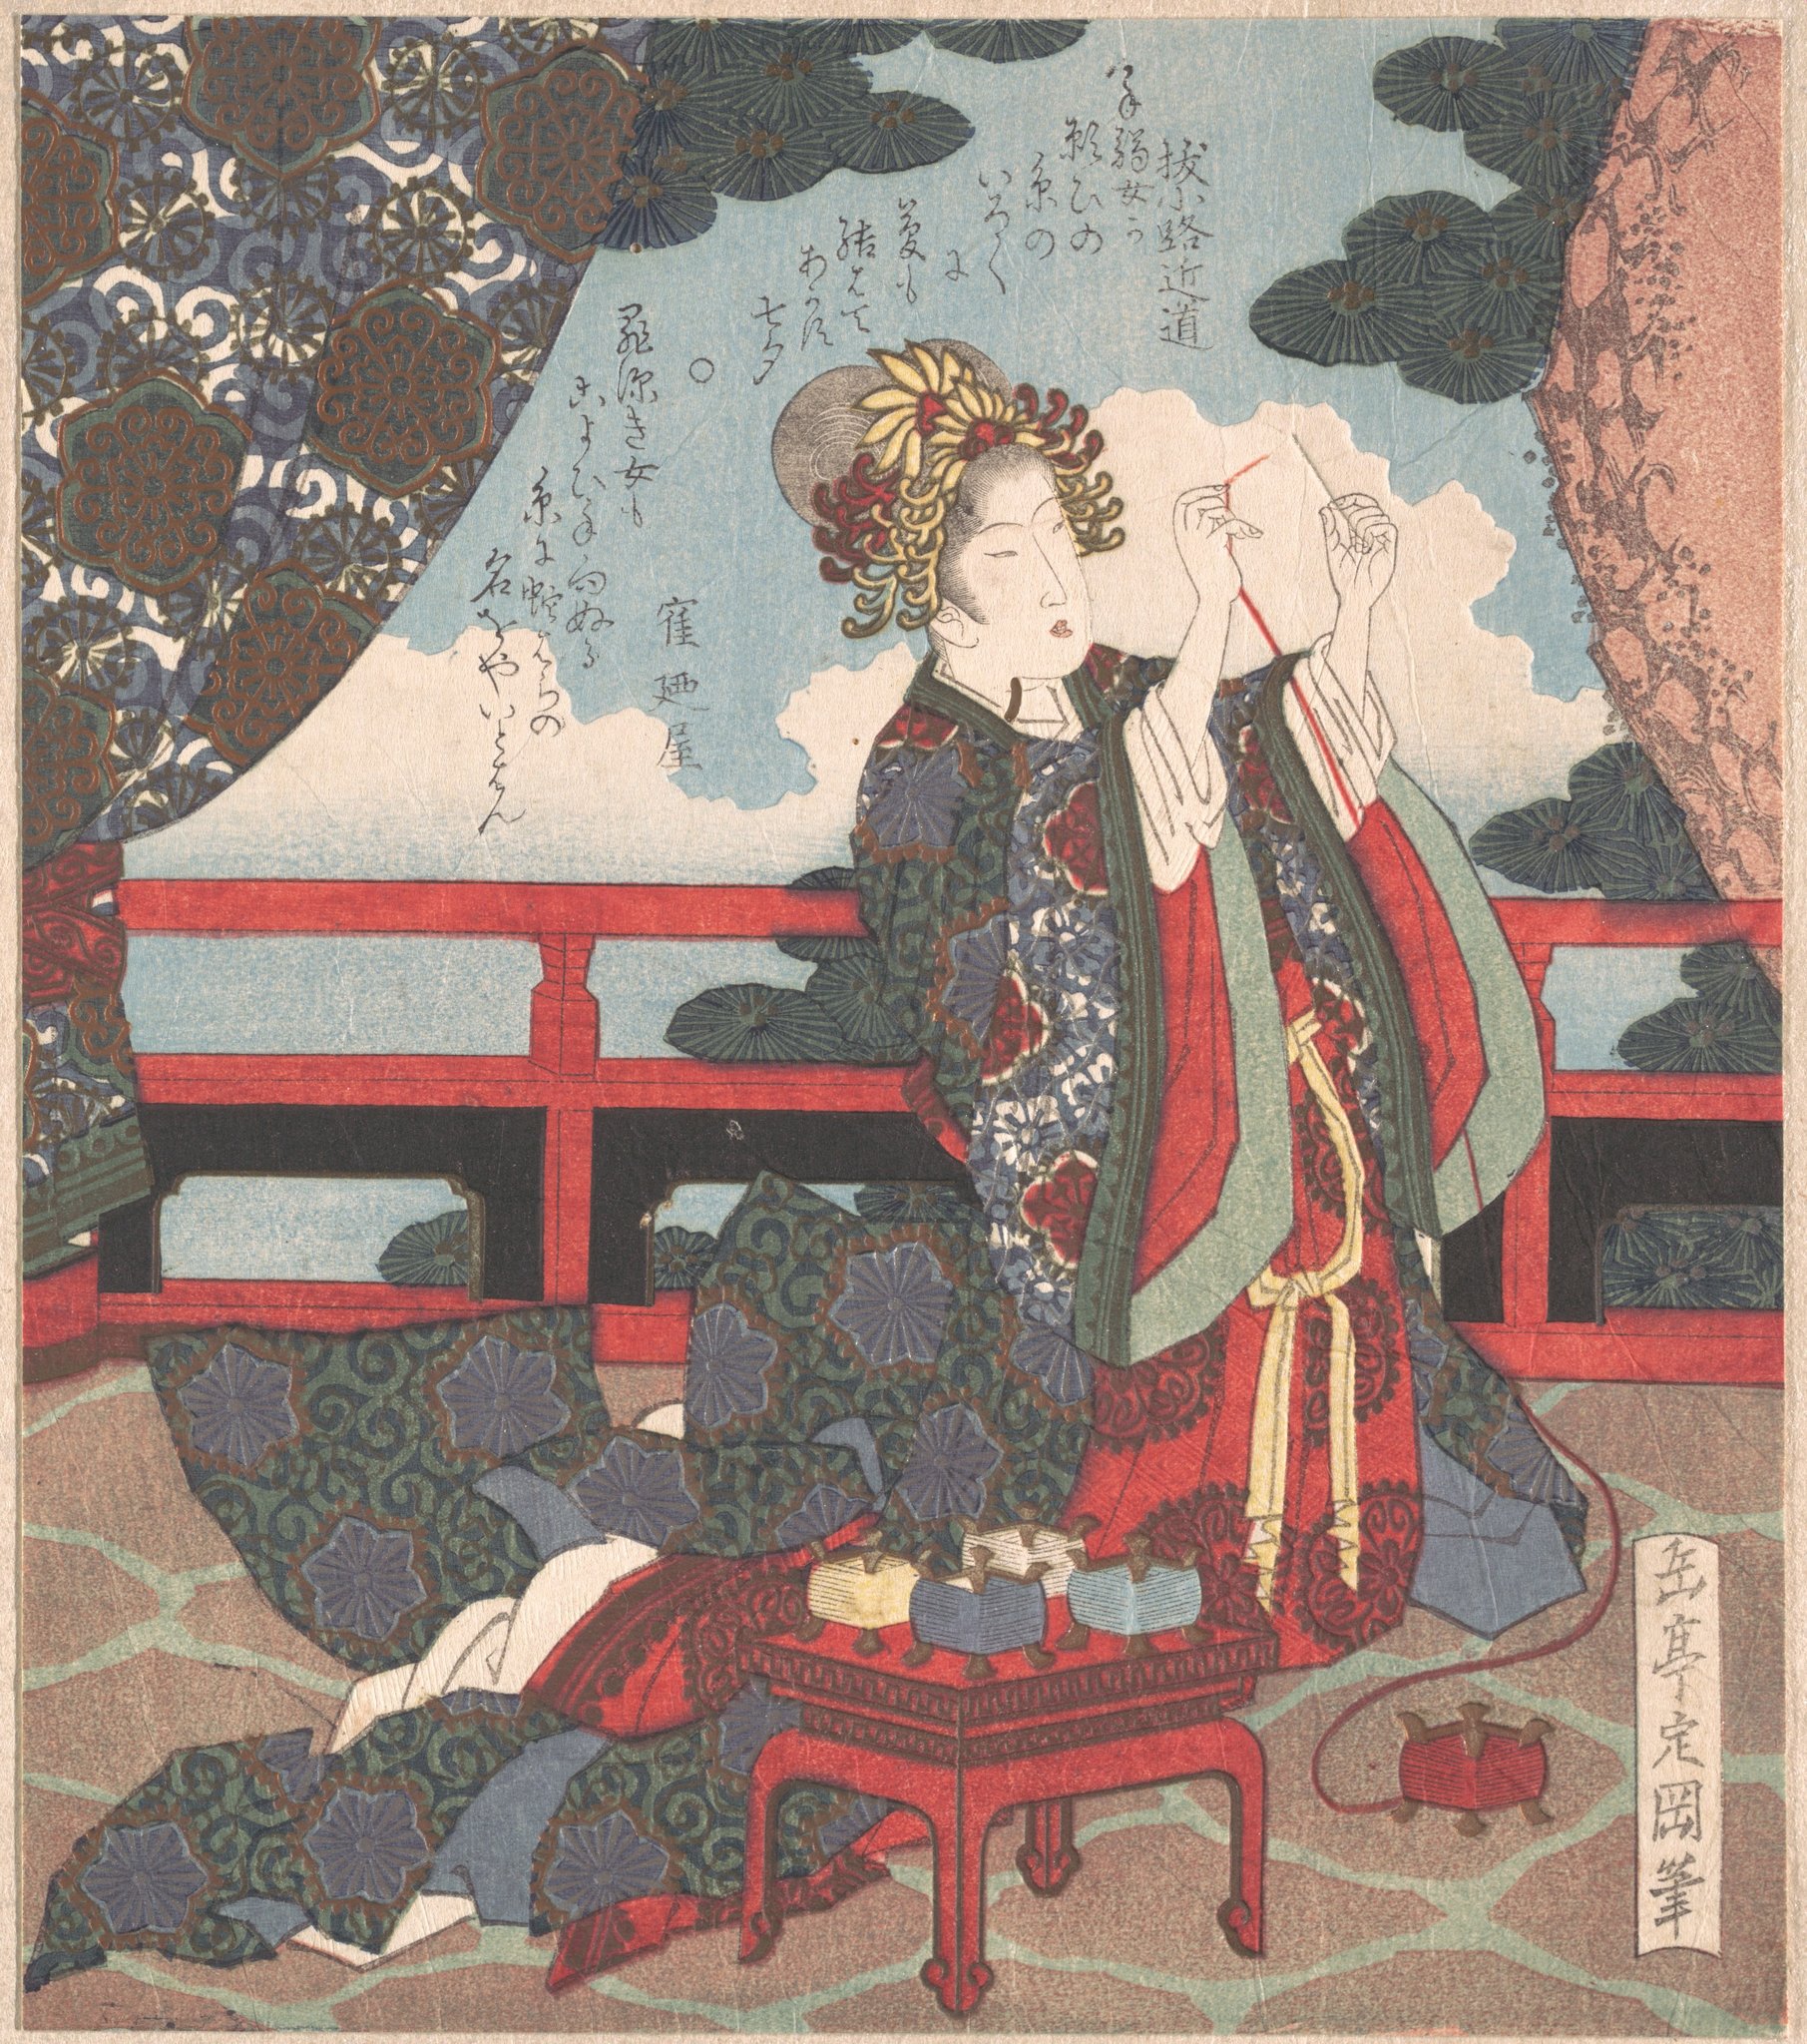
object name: print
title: Lady Threading Needle on Verandah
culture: japanese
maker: yashima gakutei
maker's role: artist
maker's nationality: japanese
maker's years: 1786-1868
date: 1801-1900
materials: ink, paper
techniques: surimono, woodblock print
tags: women,needlework